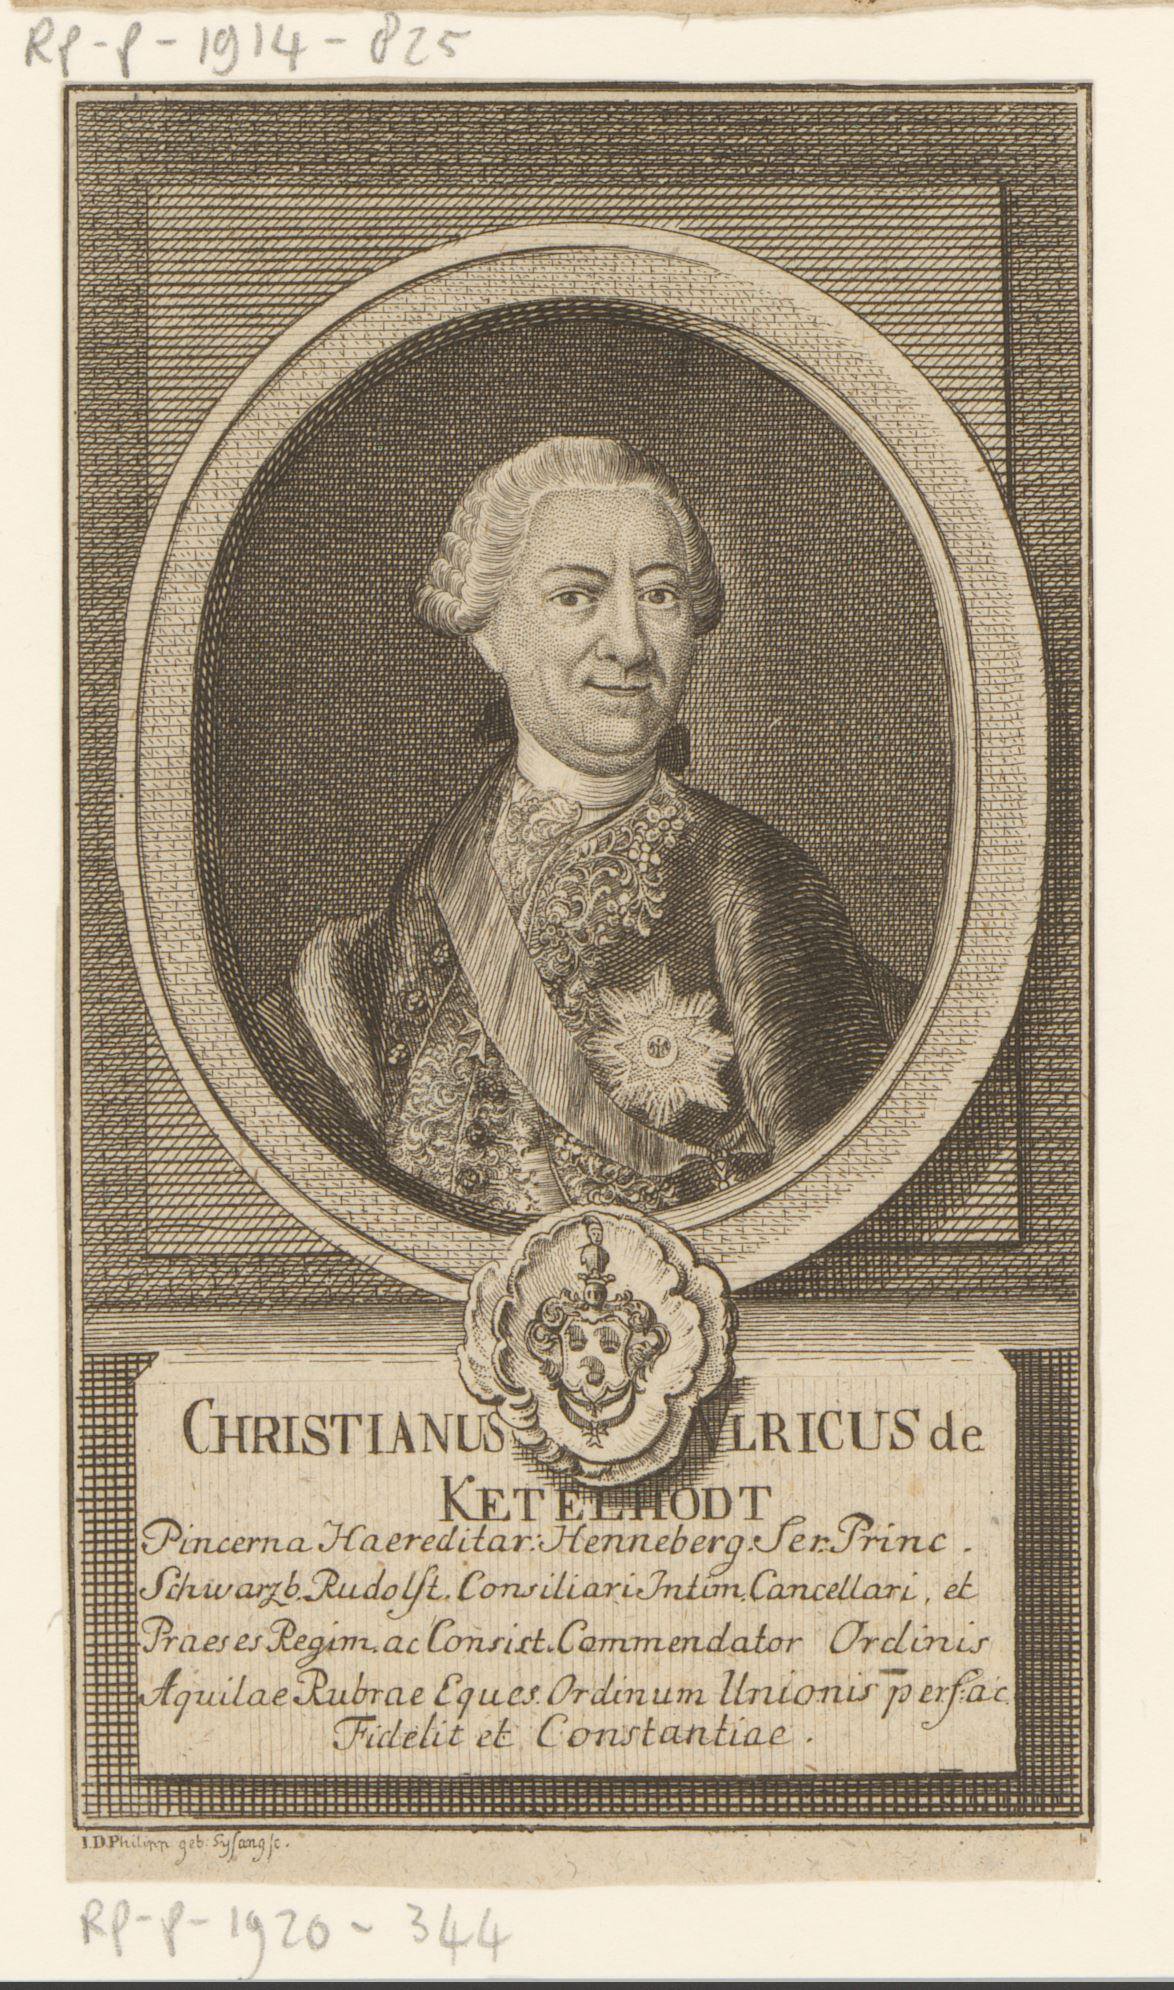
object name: print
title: Portret van Christian Ulrich von Ketelhoedt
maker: johanna dorothea sysang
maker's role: print maker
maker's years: 1729-1791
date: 1739-1791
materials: paper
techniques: engraving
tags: historical persons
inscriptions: collector's mark: Lugt 2228